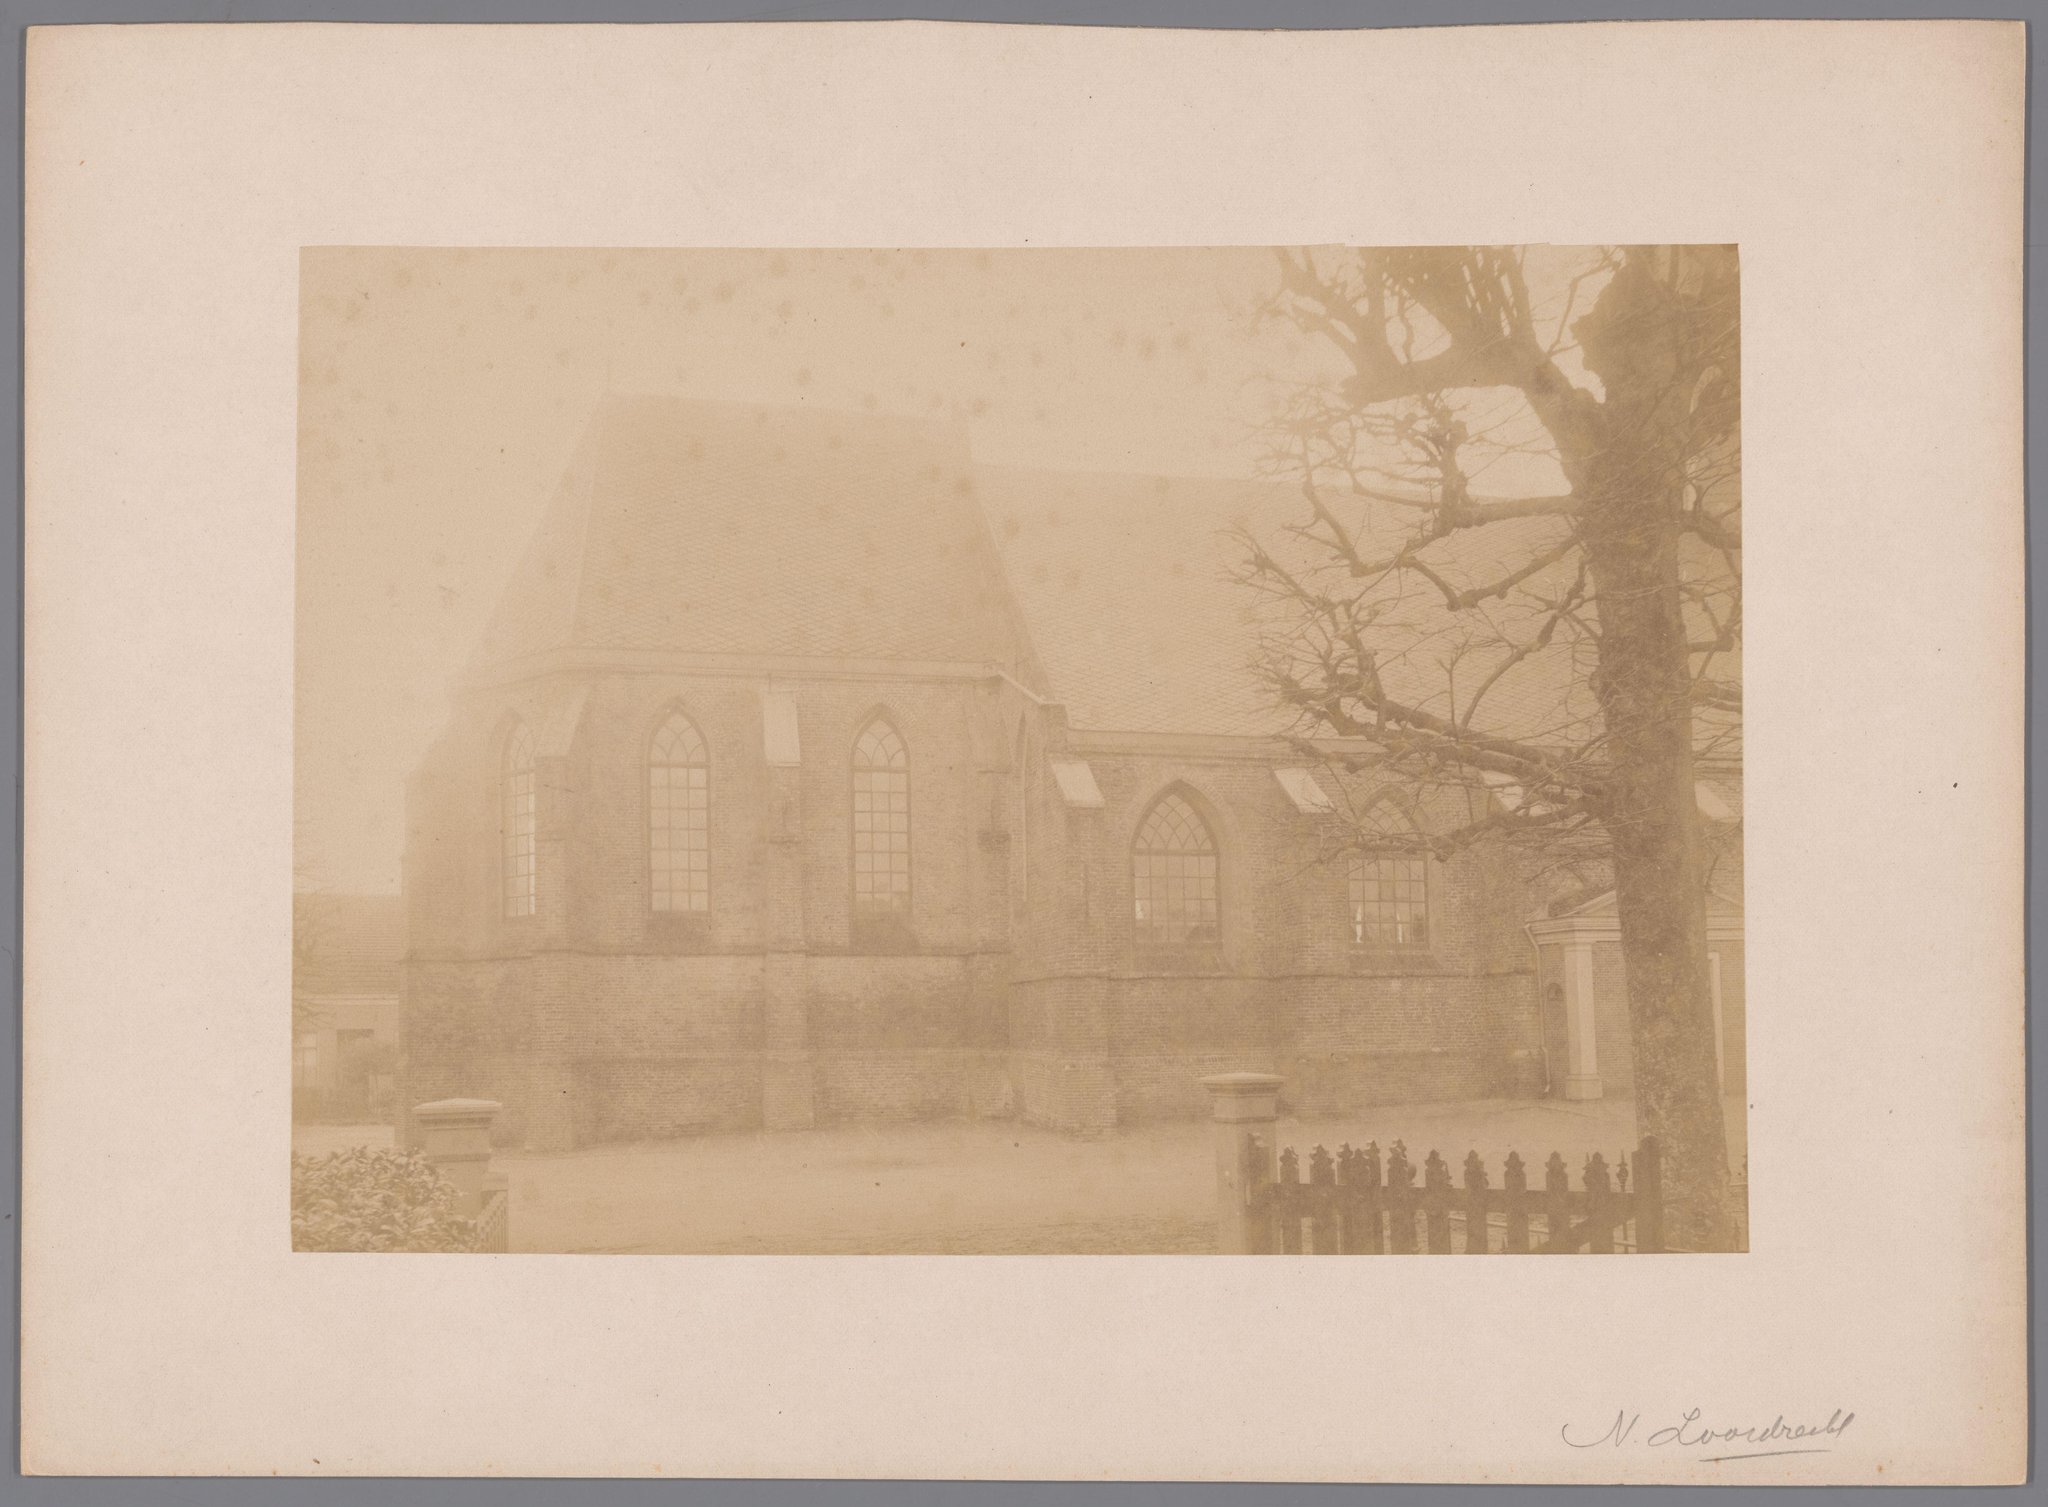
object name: photograph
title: Gezicht op het koor van de Sijpekerk te Nieuw-Loosdrecht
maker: anoniem (monumentenzorg)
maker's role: fotograaf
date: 1899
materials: cardboard, photographic support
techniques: albumen print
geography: nieuw-loosdrecht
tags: parts of church exterior and annexes: choir, nieuw-loosdrecht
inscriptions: annotation: ‘N. Loosdrecht’, annotation: ‘N.H. kerk te Nieuw Loosdrecht (U.)/ koorgedeelte/ jan 1899’